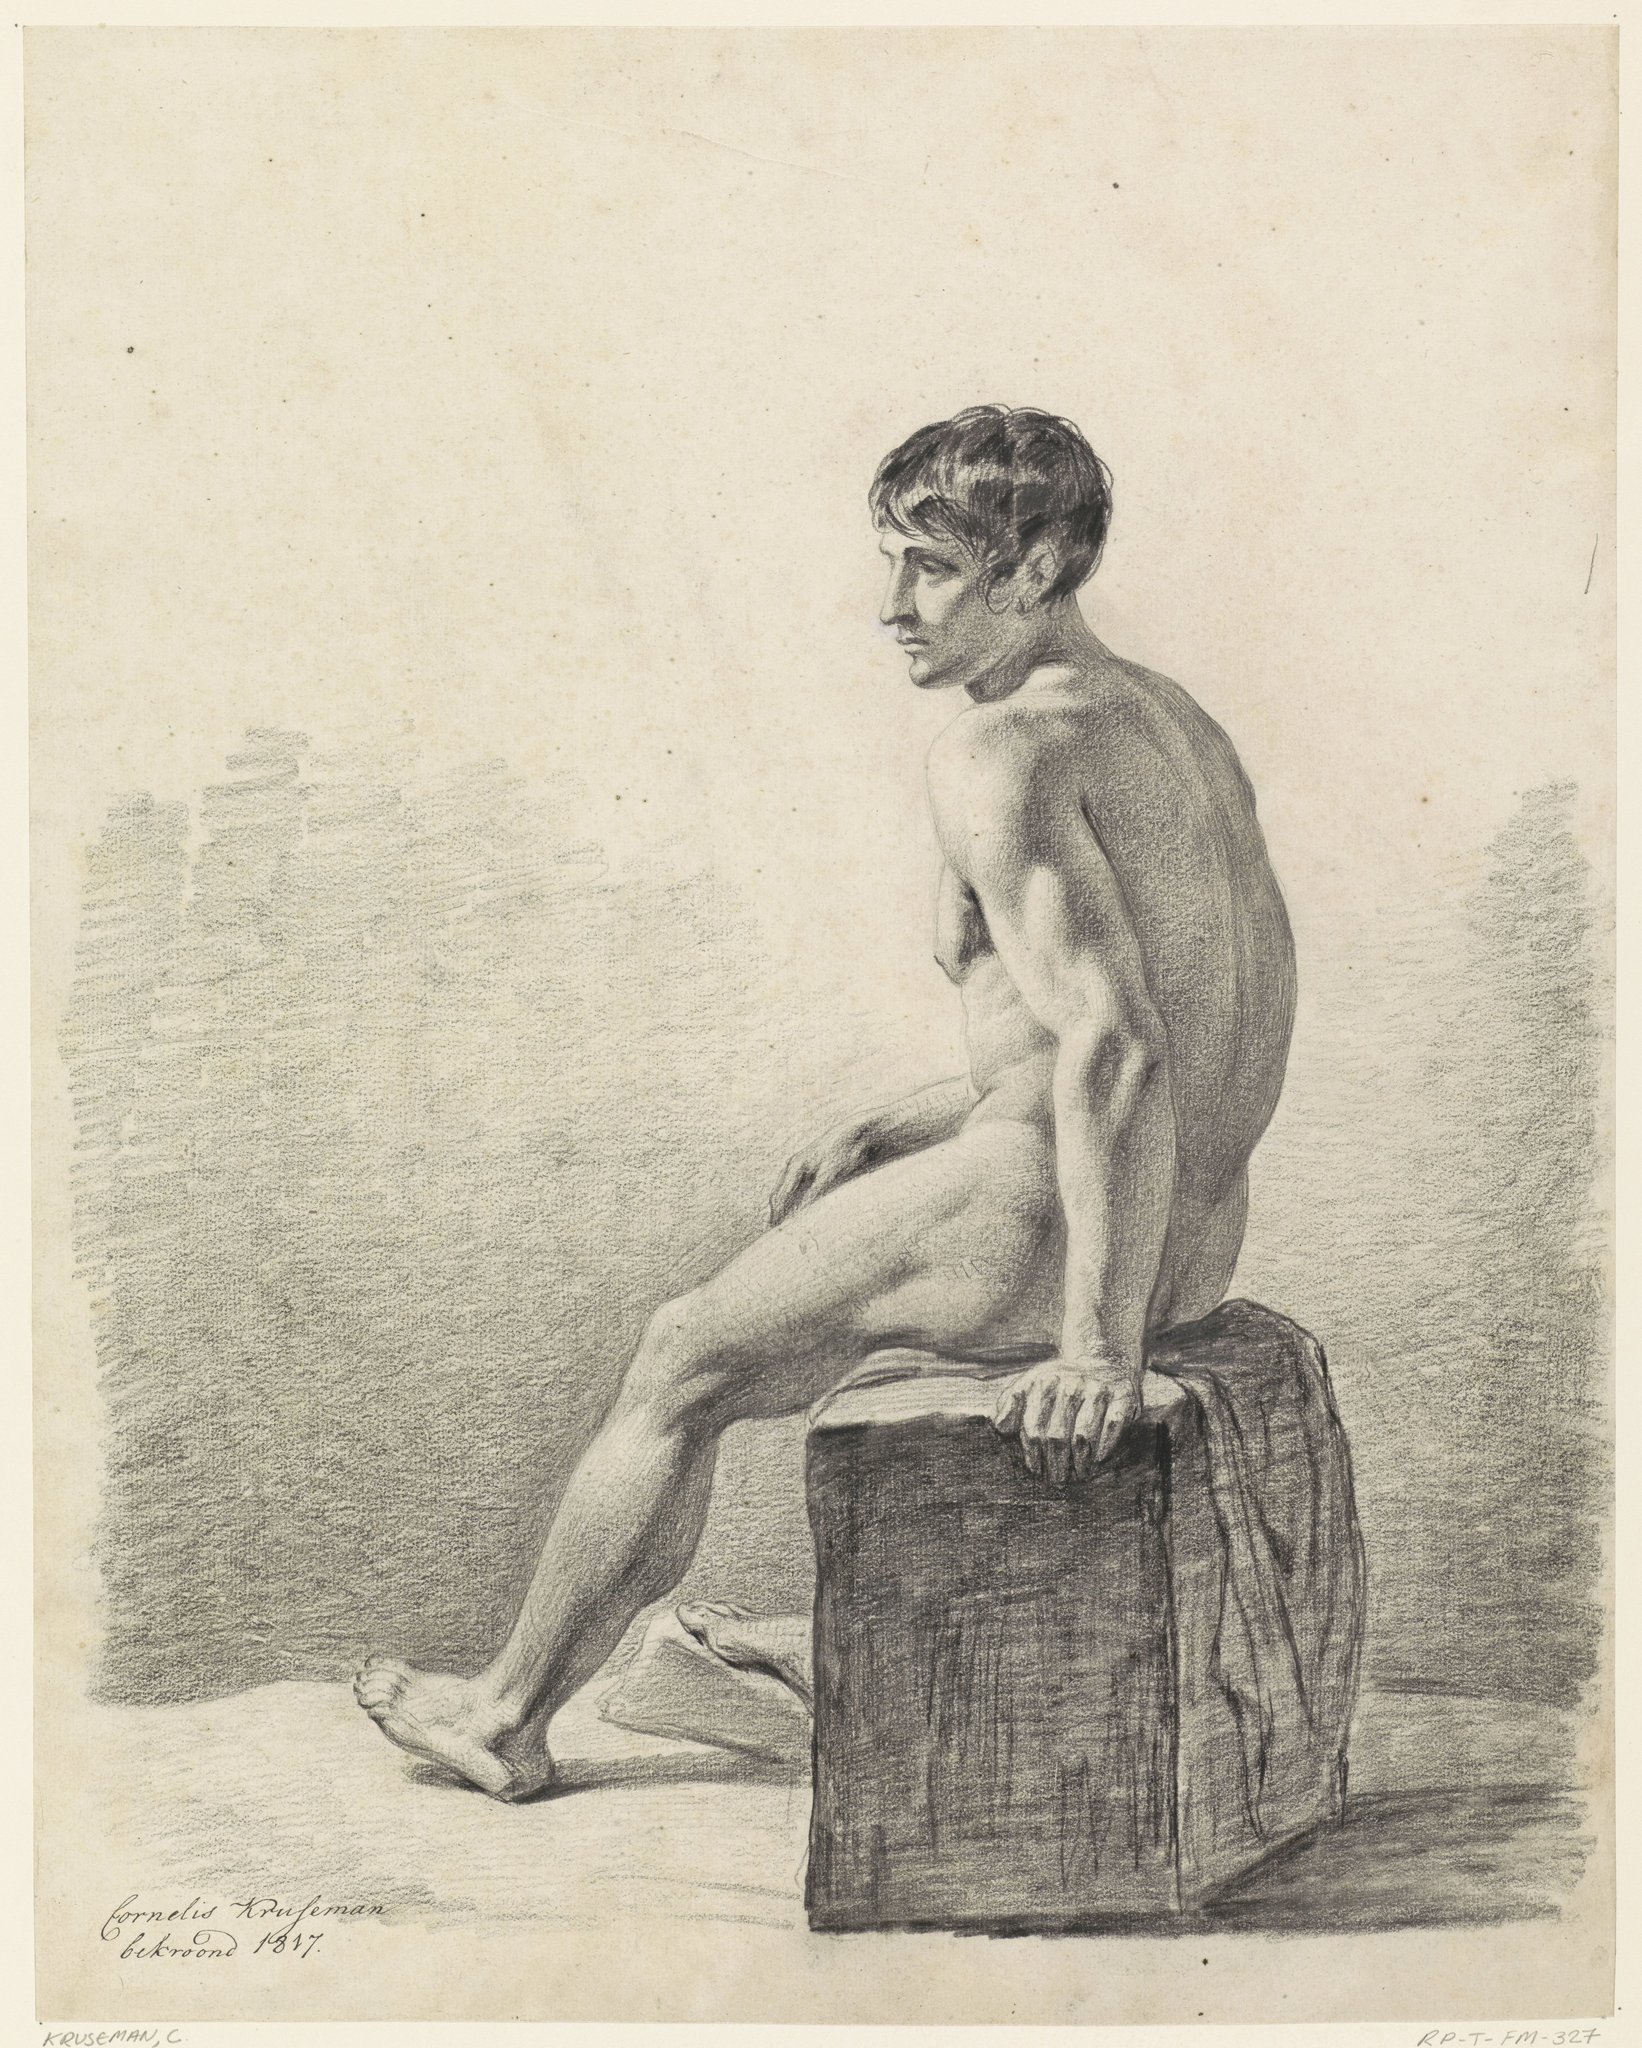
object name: drawing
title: Mannelijk zittend naakt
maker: cornelis kruseman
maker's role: draughtsman, painter, print maker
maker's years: 1797-1857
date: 1817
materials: chalk, paper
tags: sitting figure (+ nude human being)